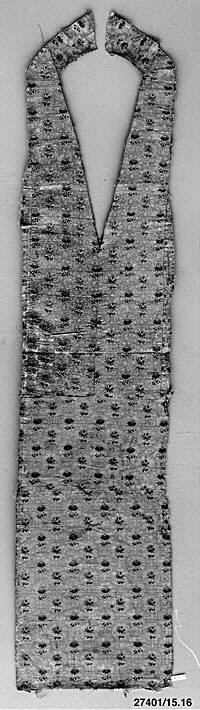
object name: textile fragment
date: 1701-1900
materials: silk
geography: iran